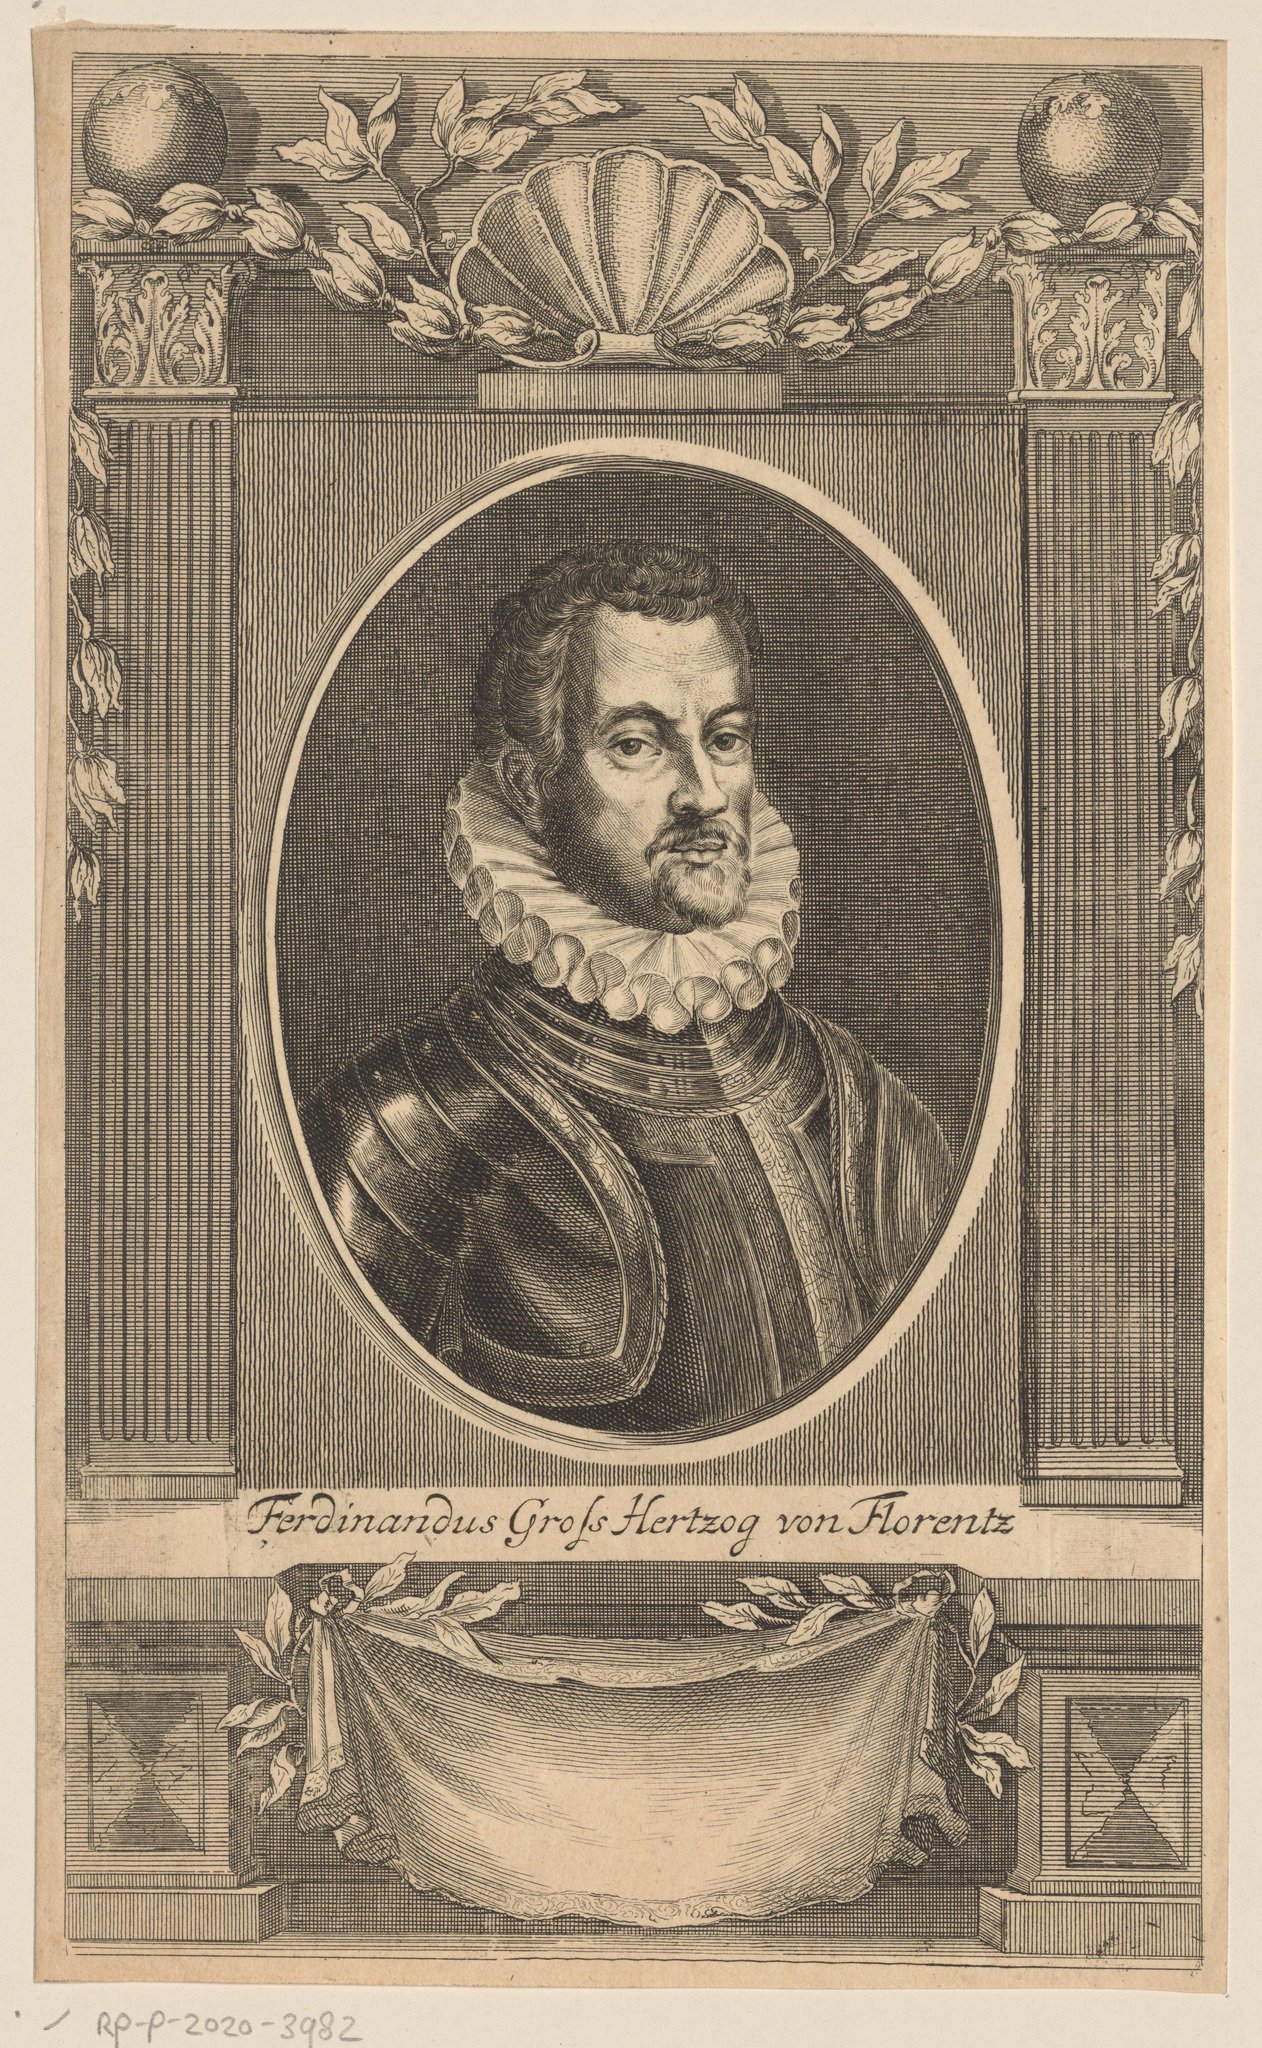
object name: print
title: Portret van Ferdinando I de' Medici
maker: Anonymous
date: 1721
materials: paper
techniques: engraving, etching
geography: germany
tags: ferdinando i de' medici, armour, historical persons, scallop, shell ~ ornament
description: Prent met andere omlijsting gebruikt in: Khevenhüller, Franz Christoph. Conterfet Kupfferstich (...). Leipzig: Moritz Georg Weidmann, 1721. Prent met deze omlijsting vermoedelijk gebruikt in een andere druk van het werk.